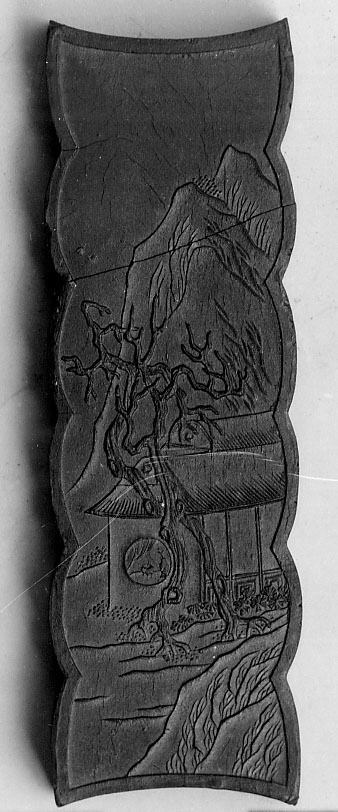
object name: ink tablet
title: Ink Tablet with "Three Rarities Hall" Design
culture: chinese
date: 1867-1933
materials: ink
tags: mountains,trees